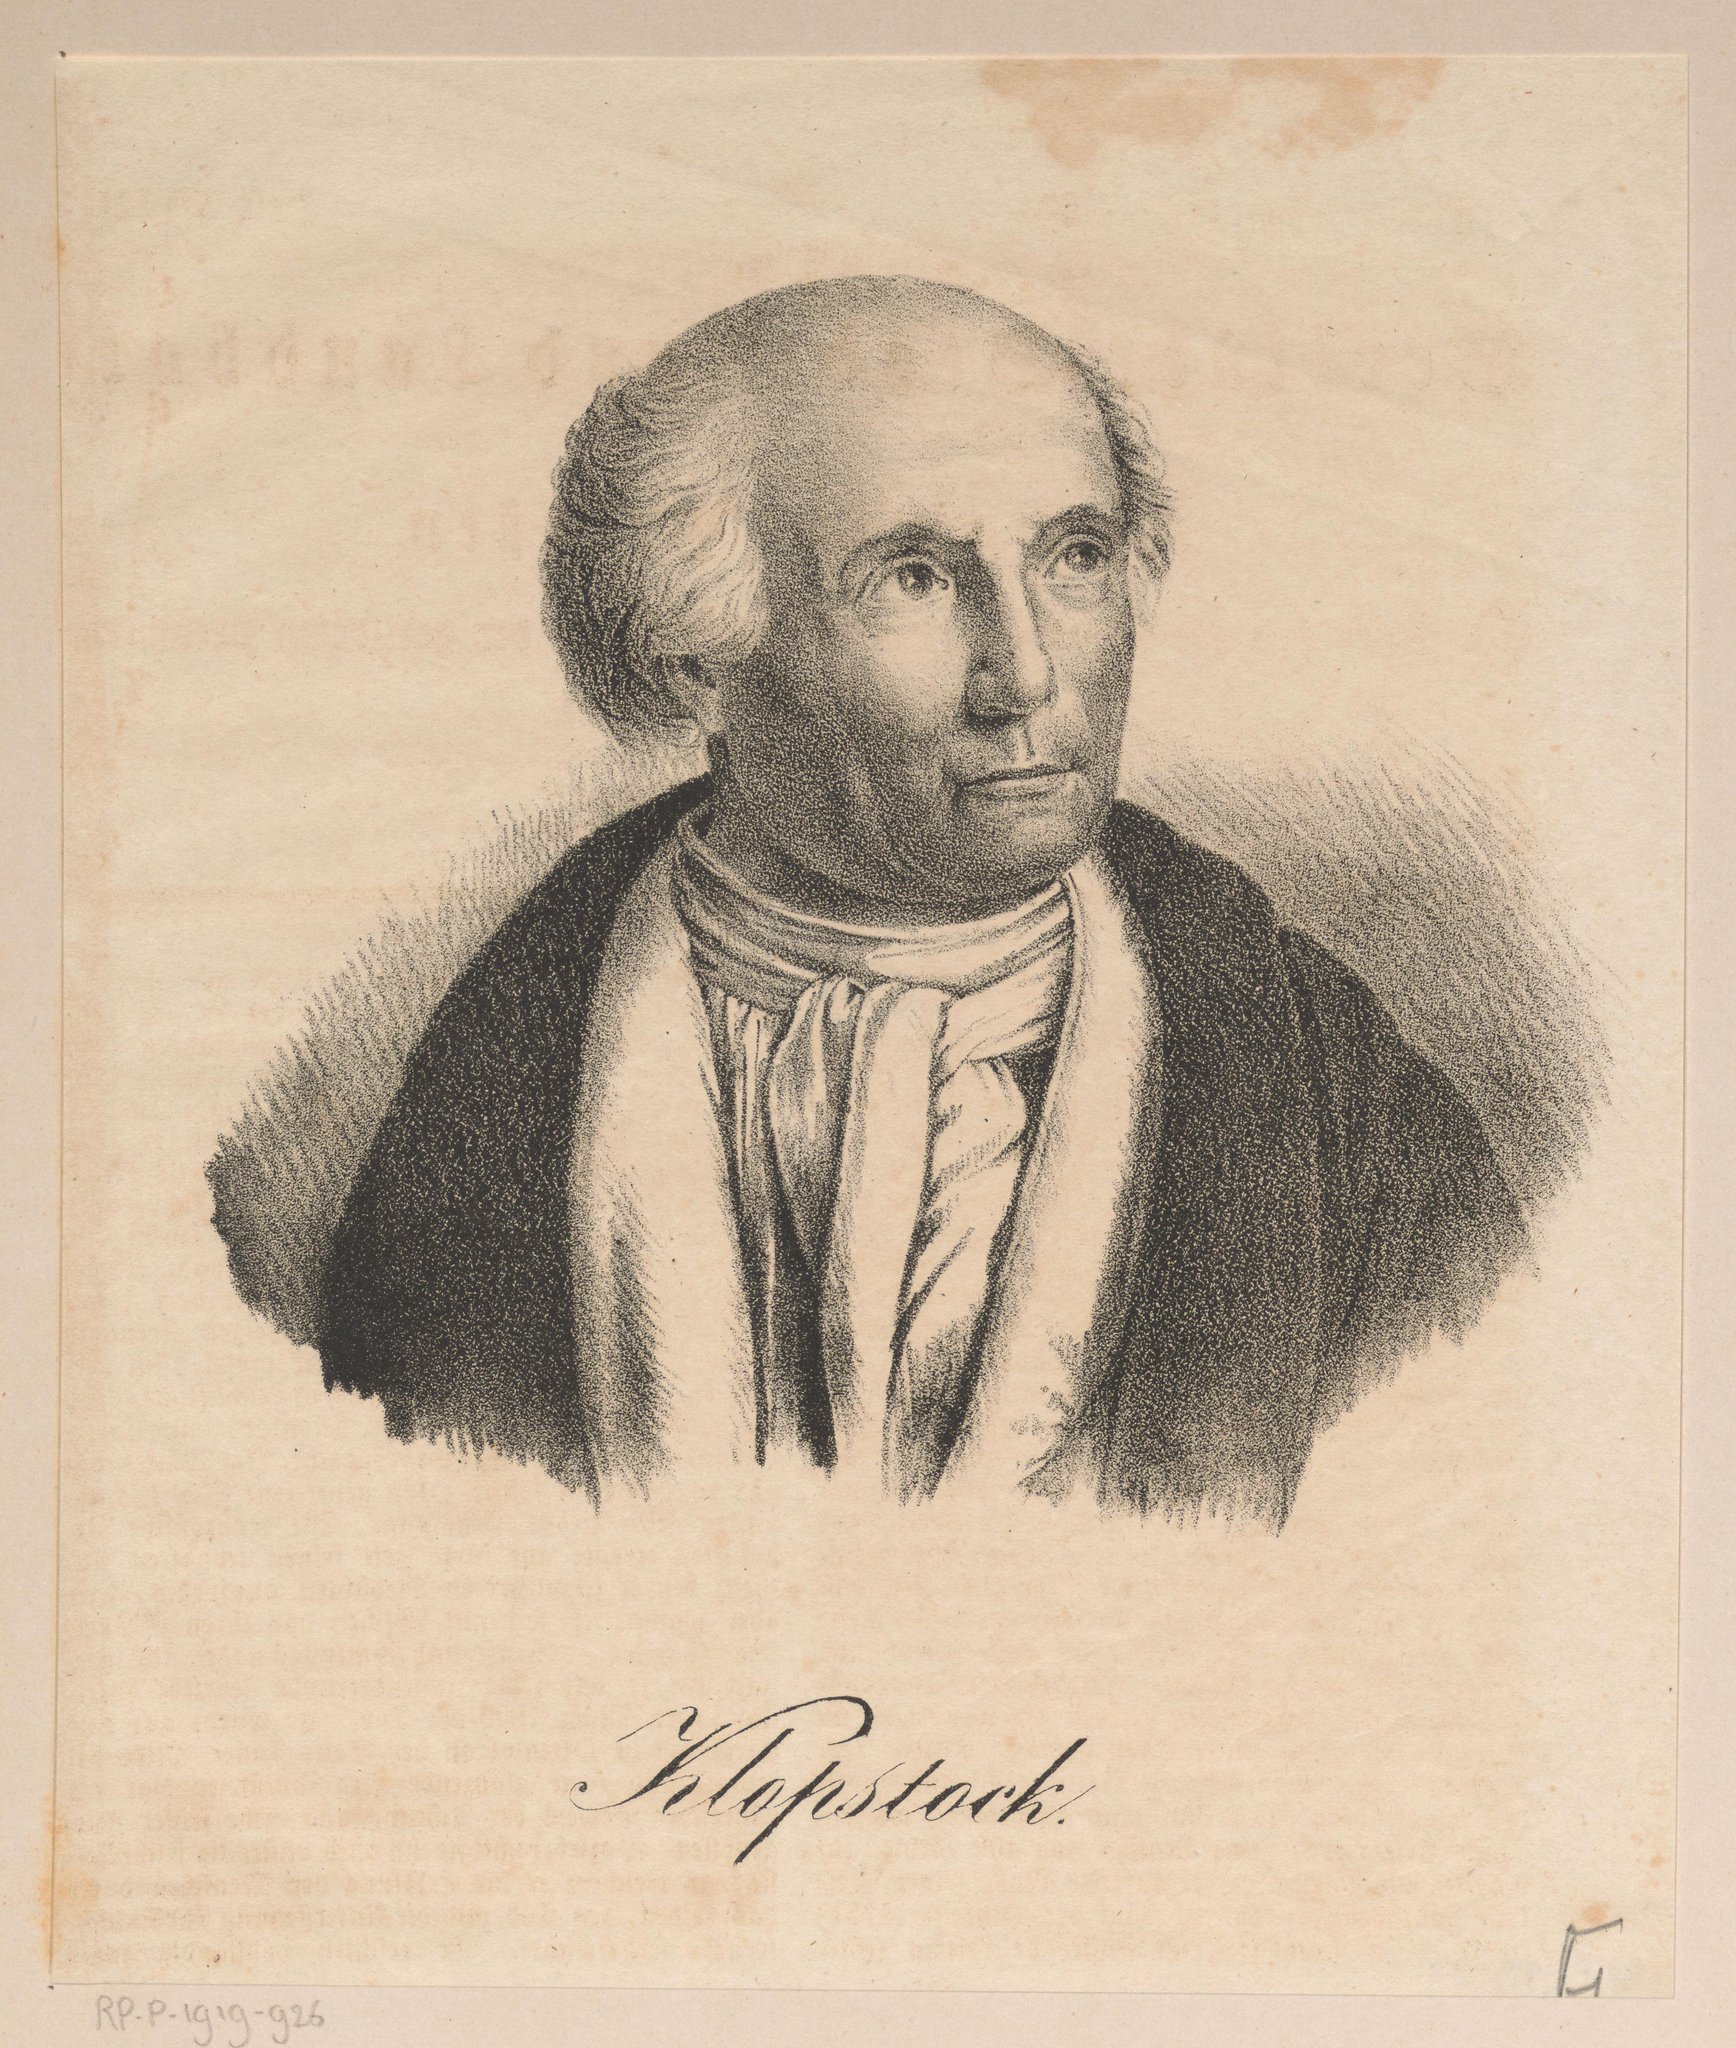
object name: print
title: Portret van Friedrich Gottlieb Klopstock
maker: Anonymous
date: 1795-1899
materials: paper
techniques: lithograph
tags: historical persons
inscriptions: collector's mark: Lugt 2228